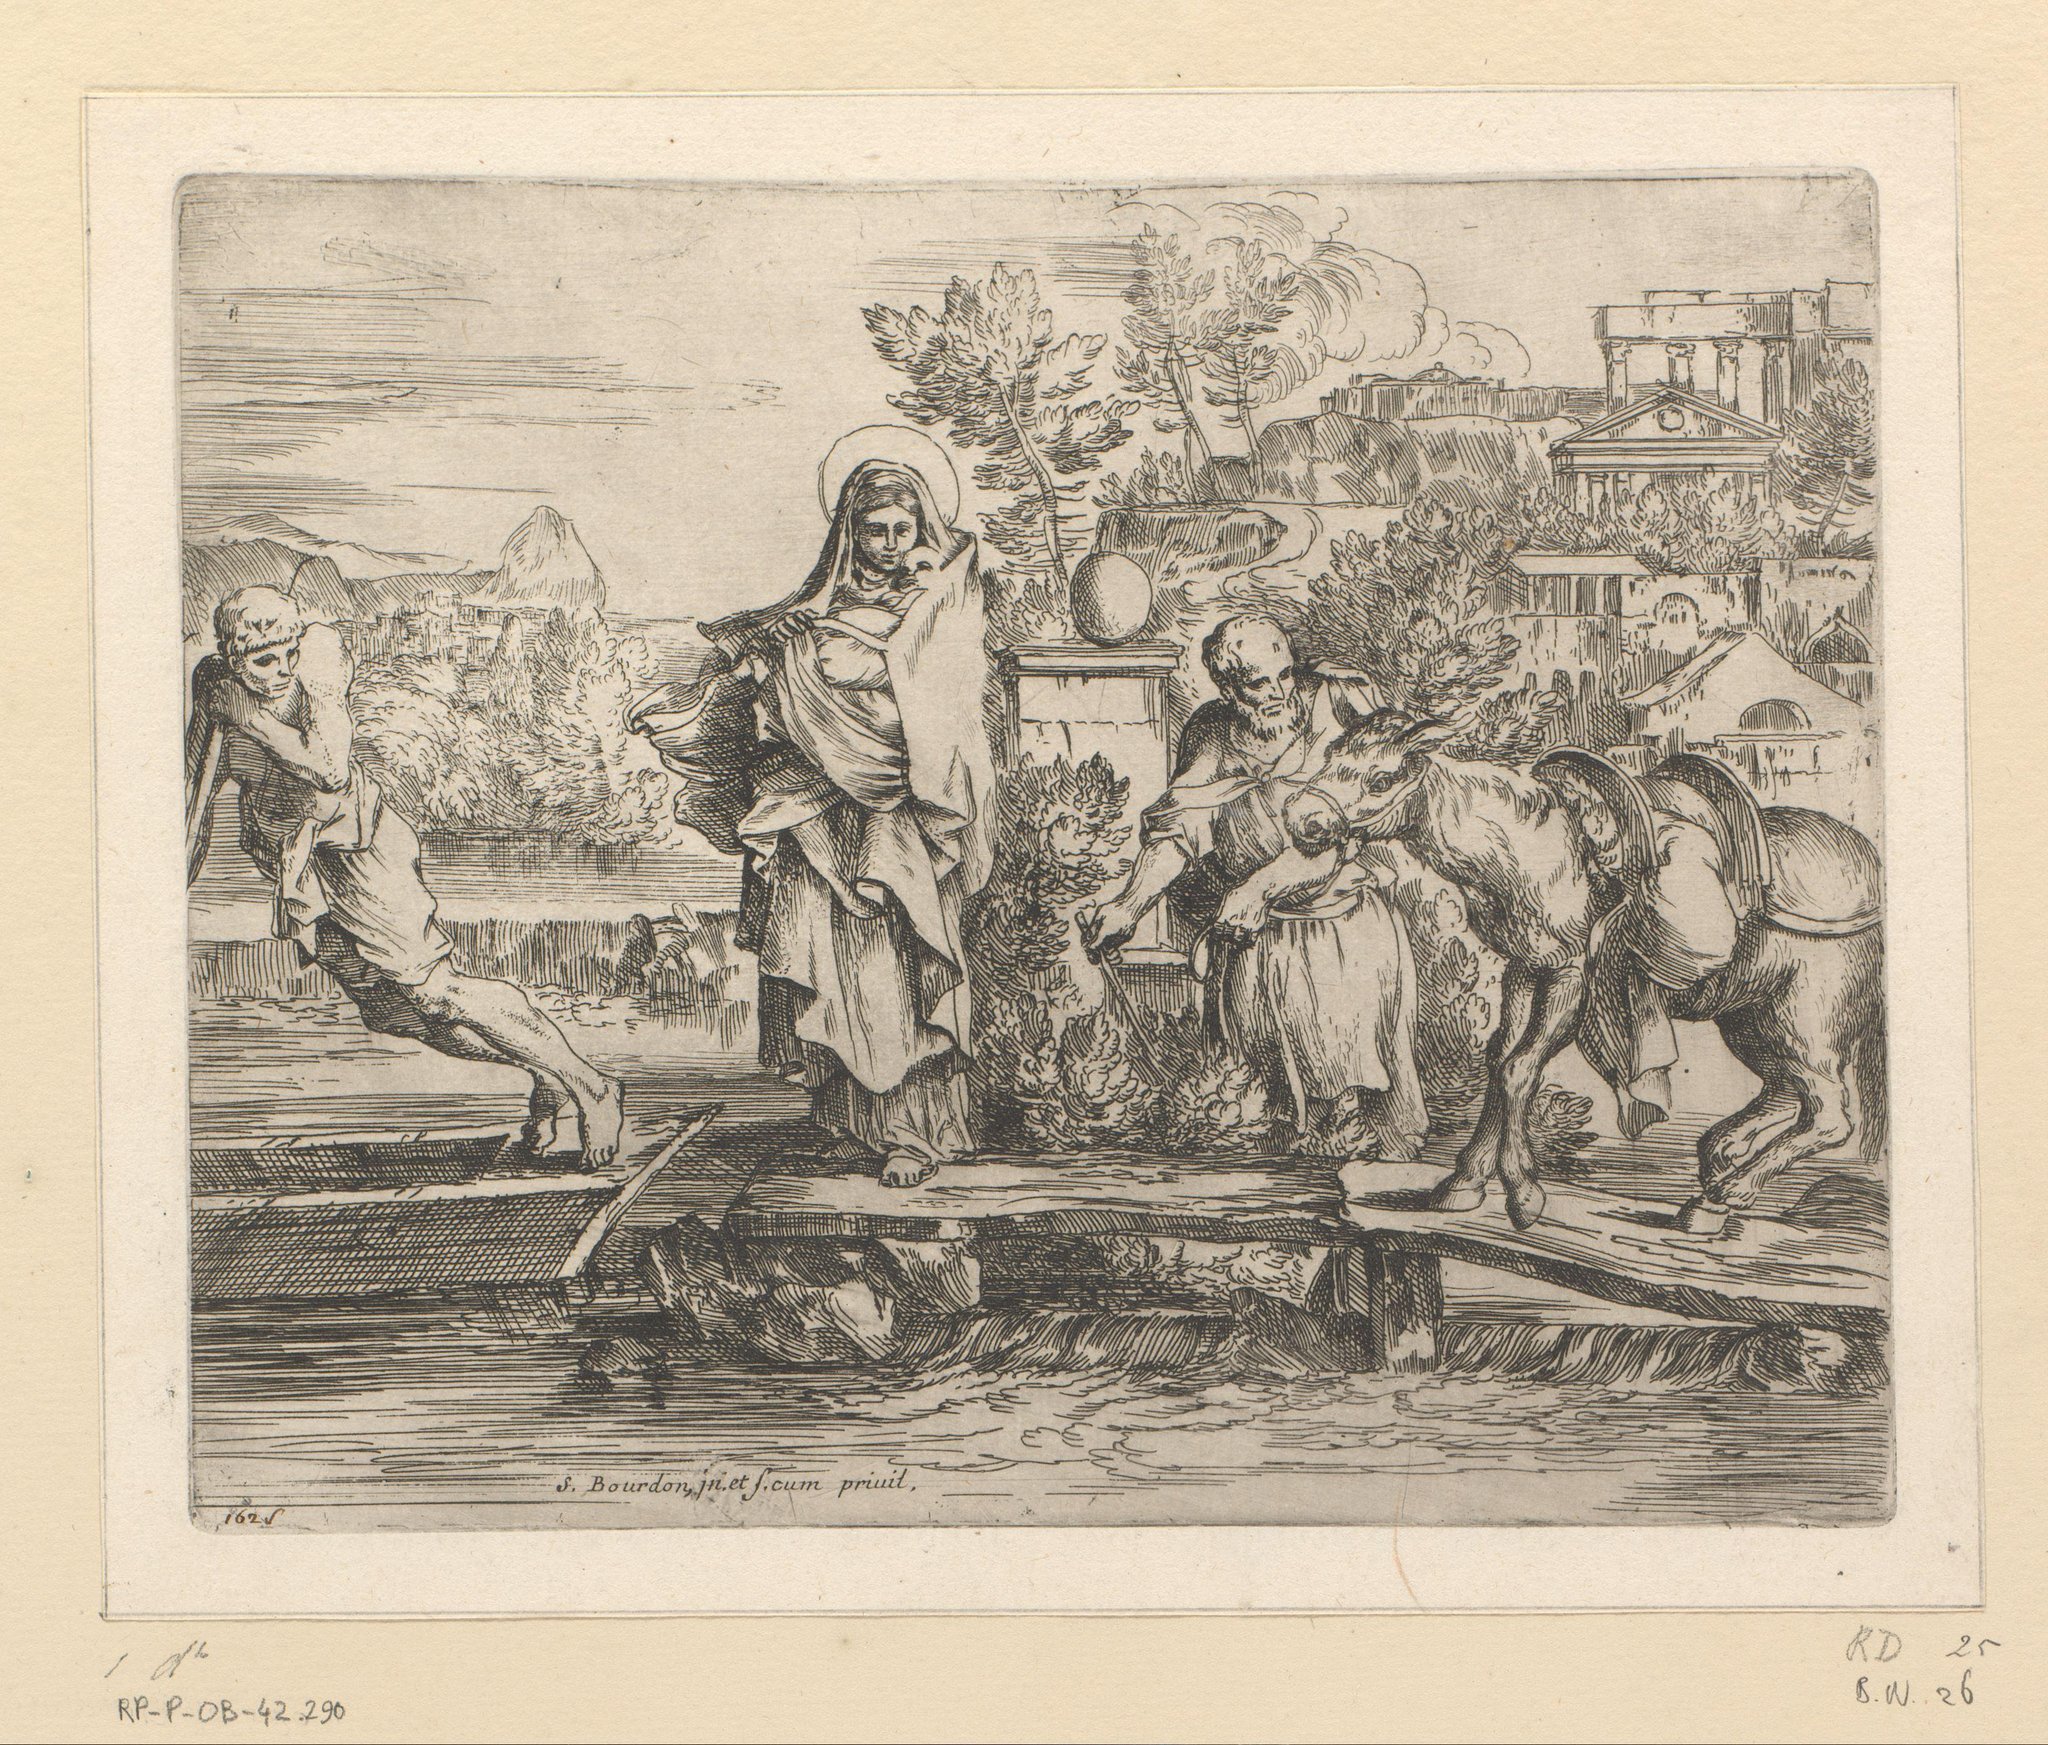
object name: print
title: Vlucht naar Egypte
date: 1626-1671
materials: paper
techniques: etching, intaglio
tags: the flight into egypt: mary, joseph, the child (and sometimes others) on their way; mary usually riding on an ass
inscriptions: number: ‘1628’, collector's mark: Lugt 240, inscription: ‘de vlugt van egipten door bourdon / no 45’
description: Maakt deel uit van een serie van zes prenten met taferelen uit de vlucht naar Egypte.